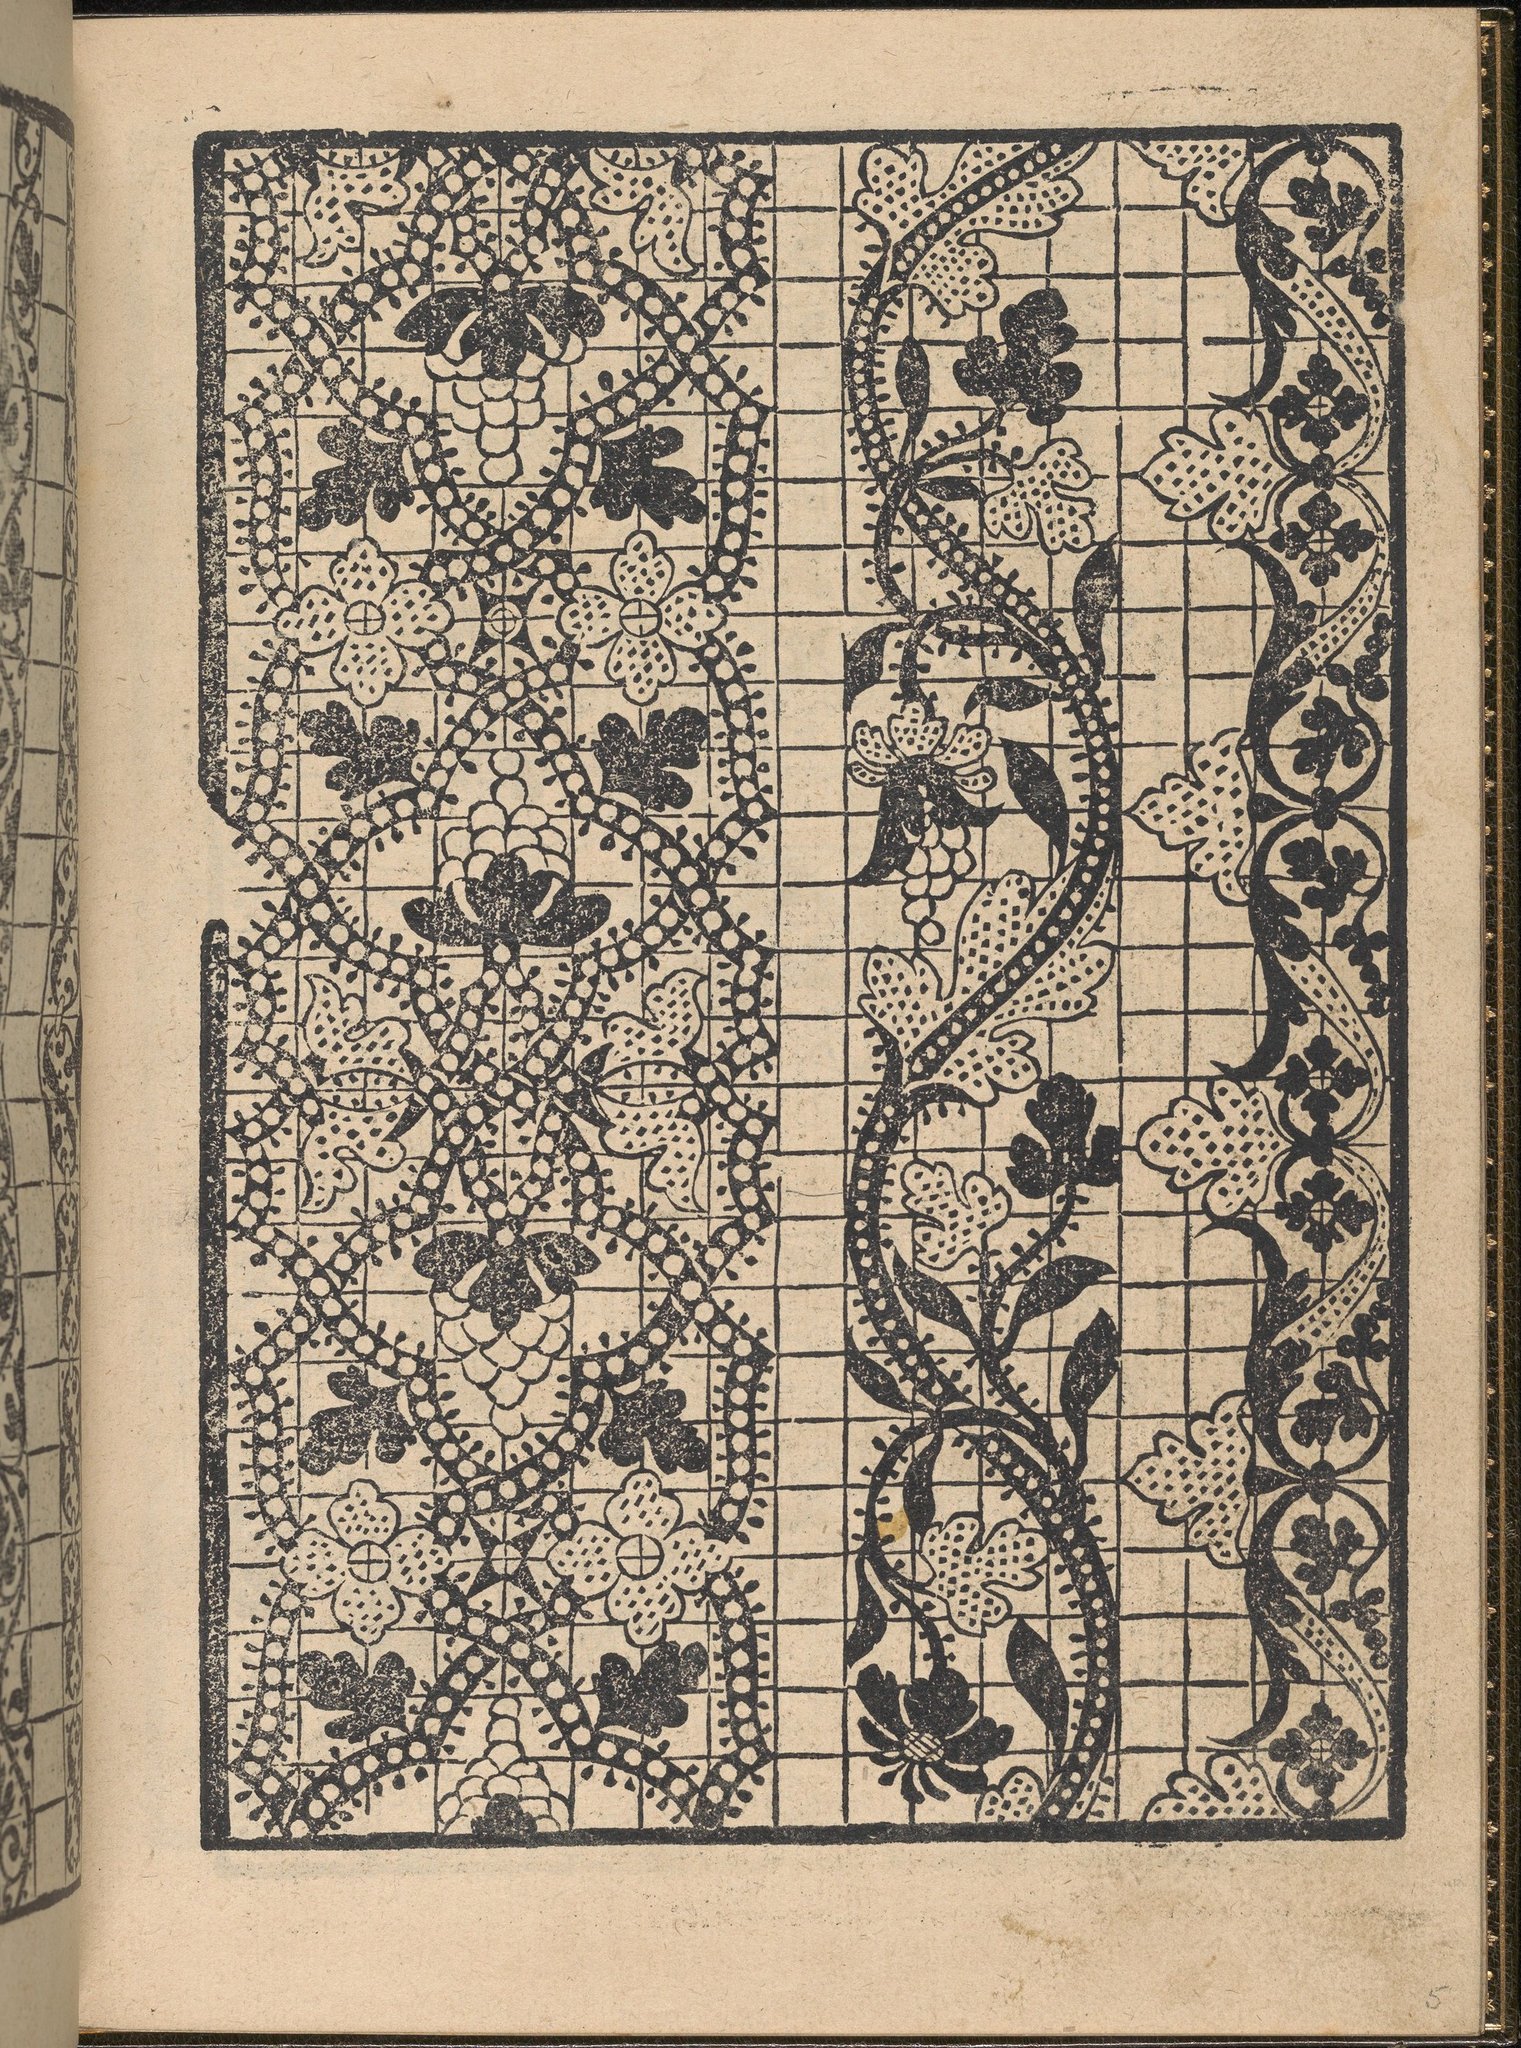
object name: book print ornament architecture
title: La Gloria et l'Honore di Ponti Tagliati, E Ponti in Aere, page 3 (recto)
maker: matteo pagano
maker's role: publisher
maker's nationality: italian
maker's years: 1515-1588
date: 1556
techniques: woodcut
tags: flowers,vines